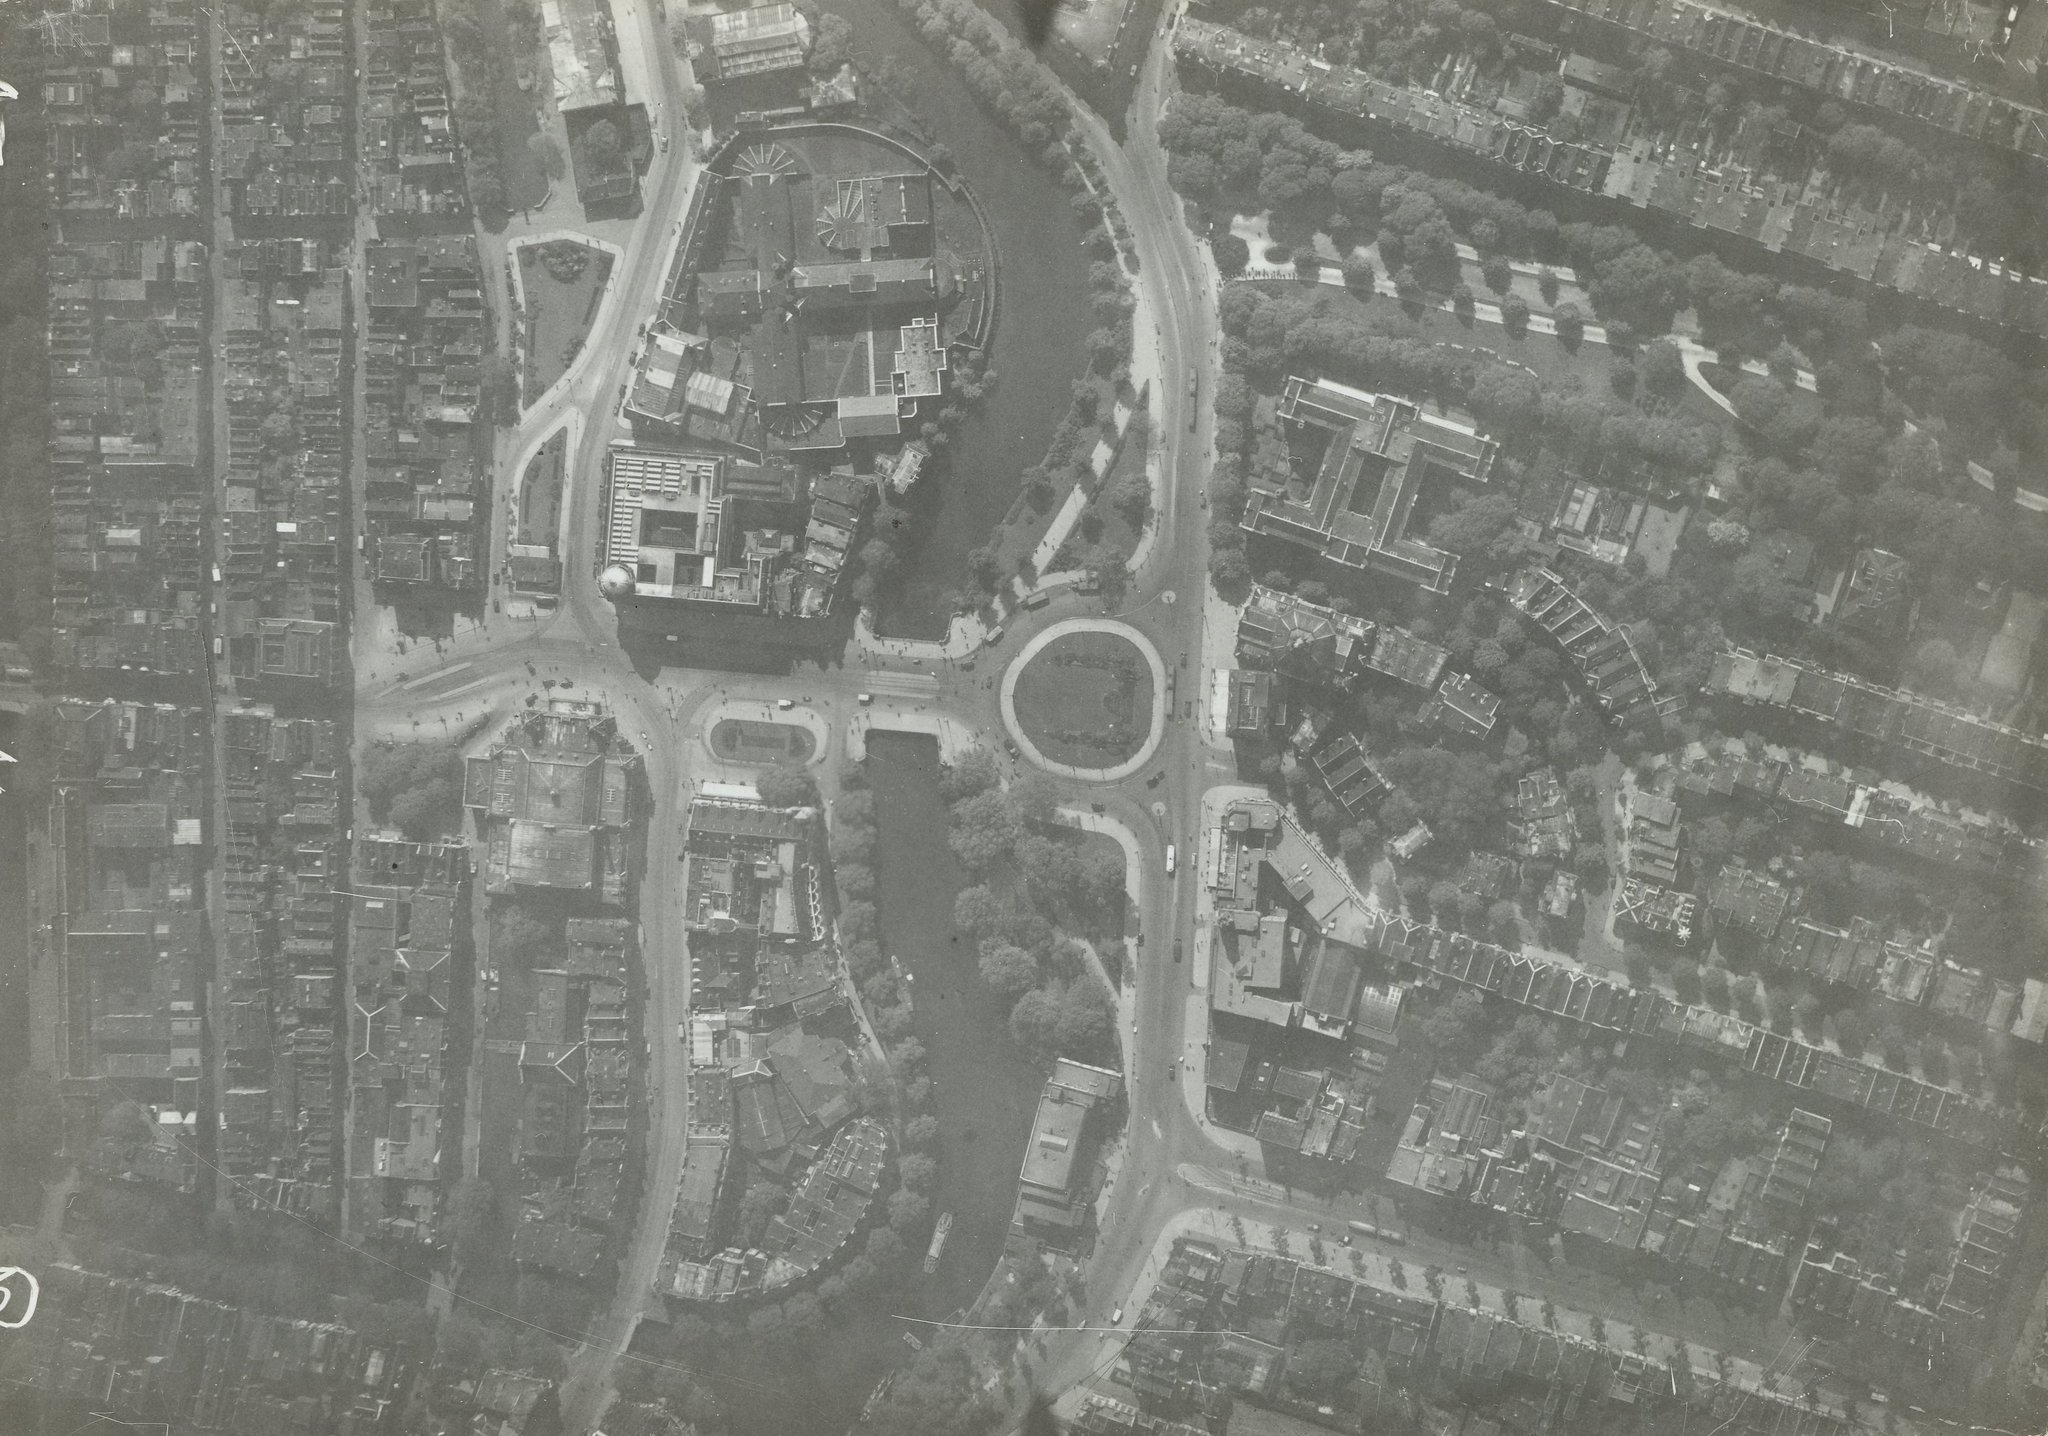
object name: photograph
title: Het Leidseplein in Amsterdam vanuit de lucht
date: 1930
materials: photographic support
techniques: photography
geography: amsterdam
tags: leidseplein